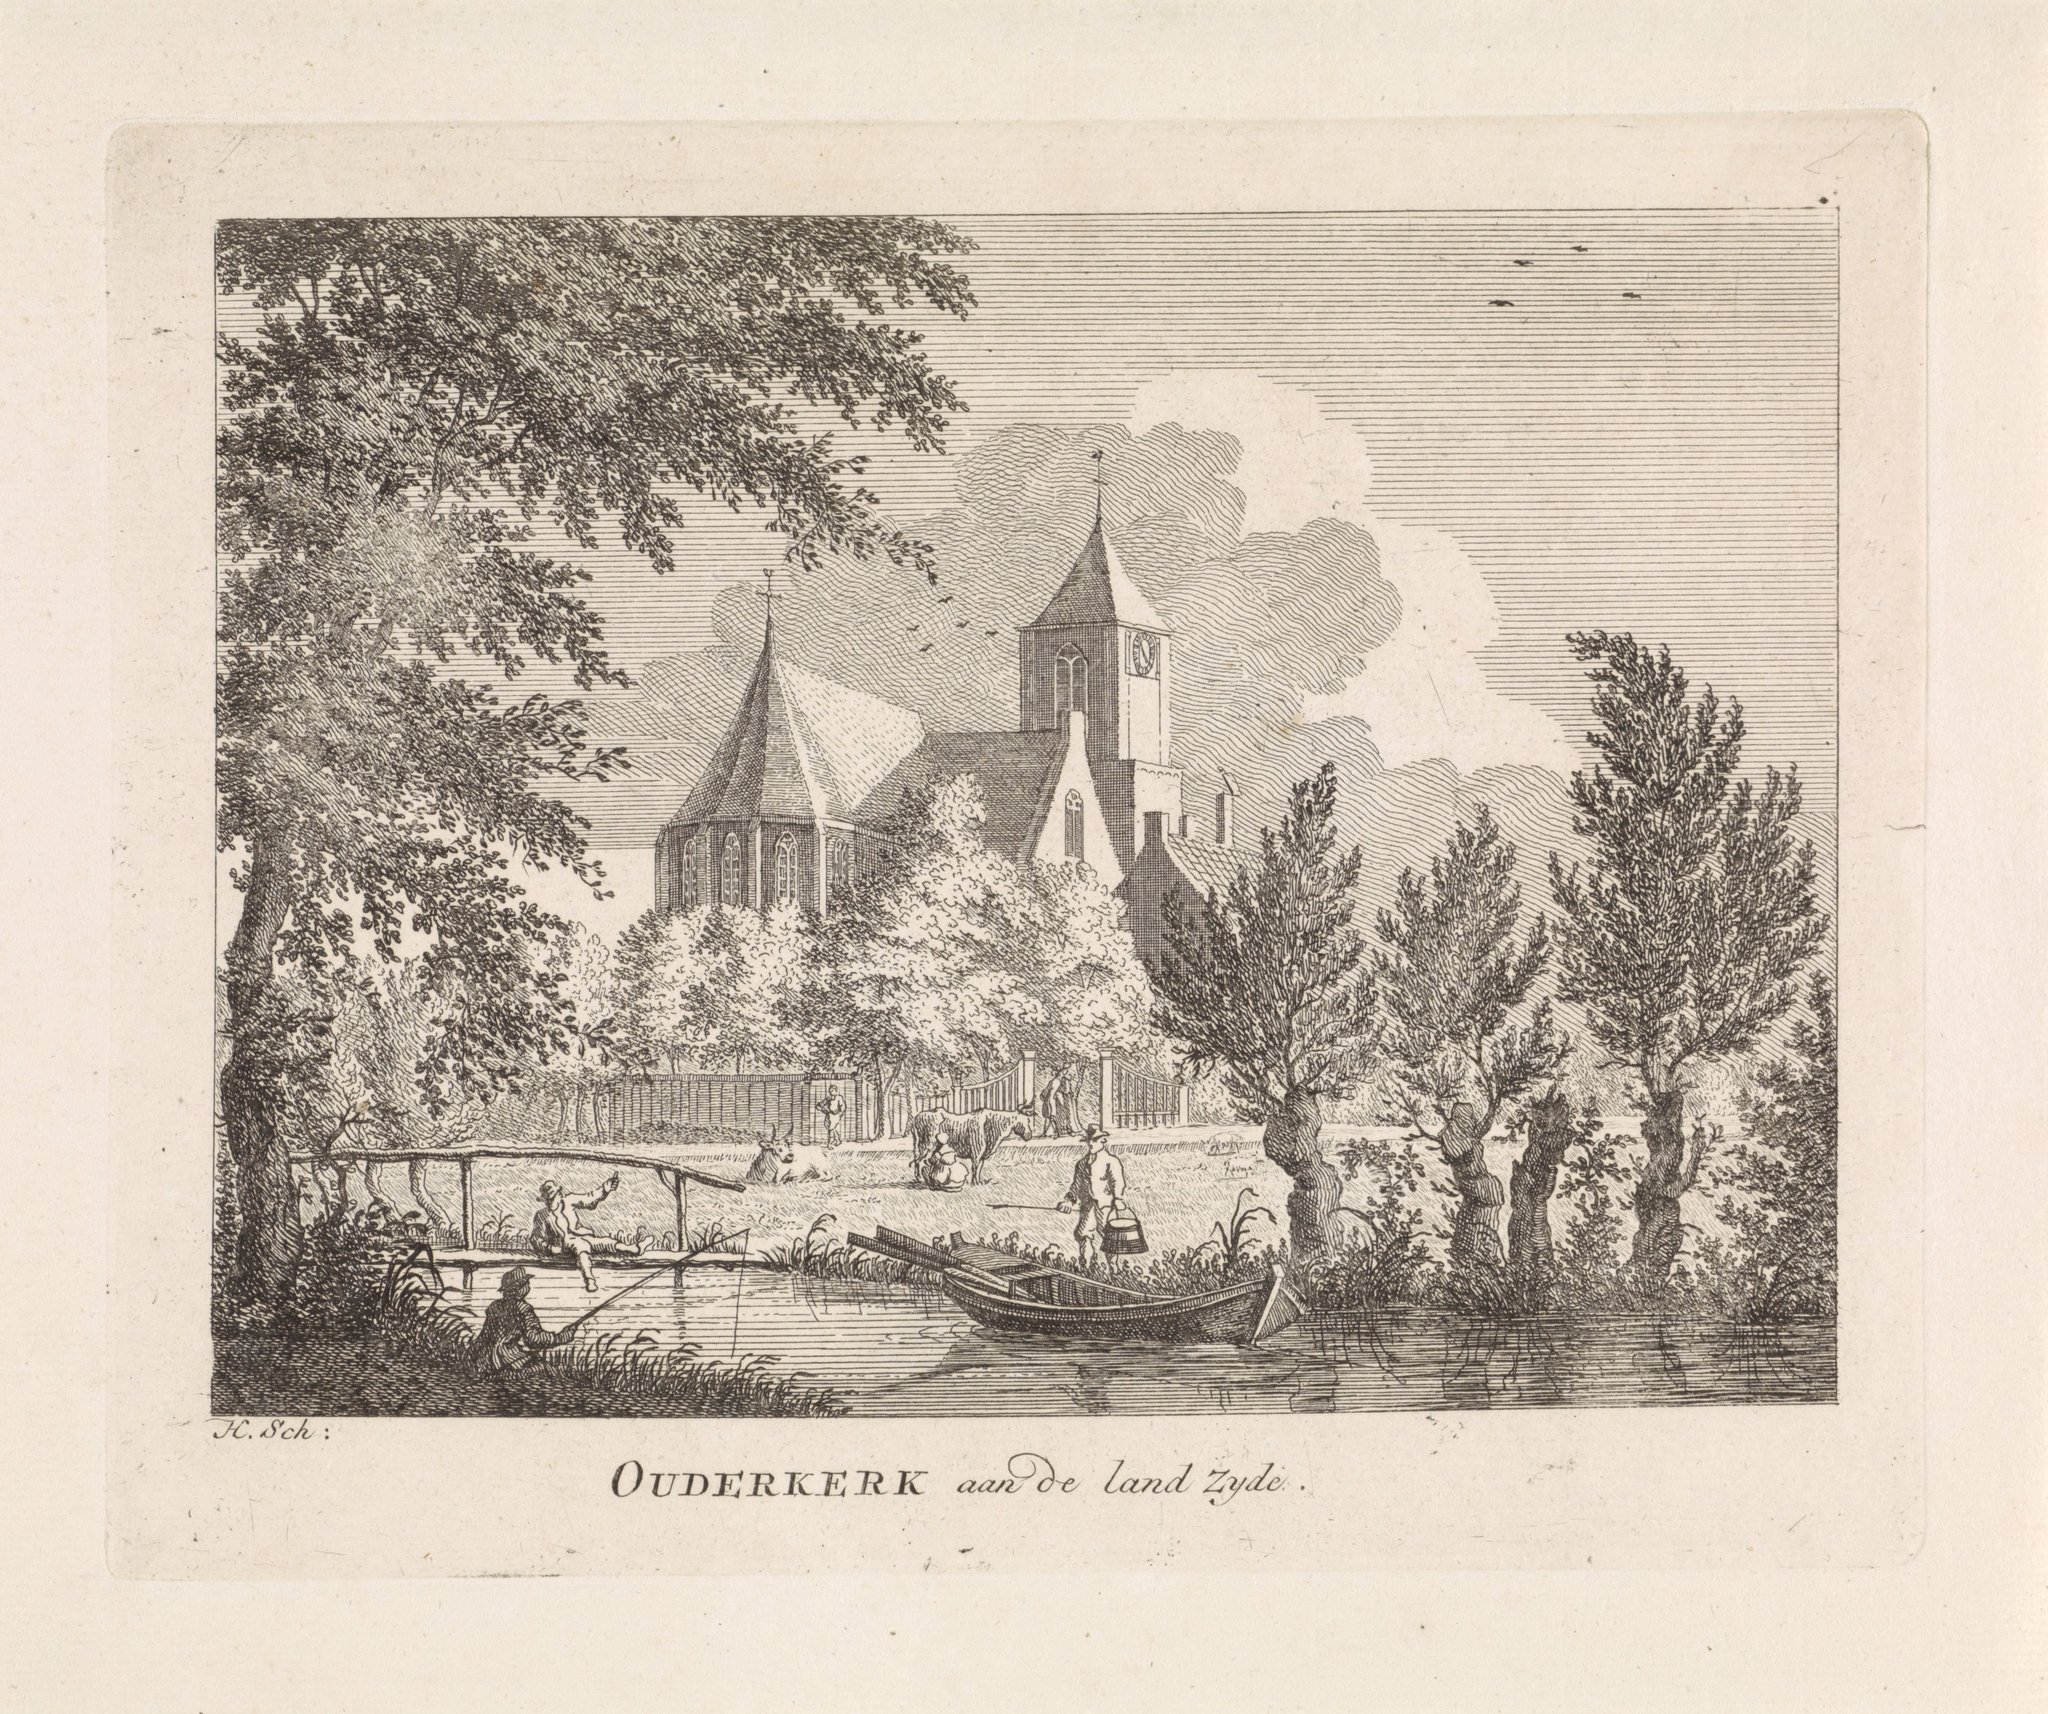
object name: print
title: Gezicht op Ouderkerk aan de Amstel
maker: hermanus petrus schouten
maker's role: draughtsman, painter, print maker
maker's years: 1747-1822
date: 1762-1822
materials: paper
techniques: etching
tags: village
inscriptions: collector's mark: Lugt 2228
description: Landelijk tafereel bij een sloot met knotwilgen met zicht op de kerk in Ouderkerk aan de Amstel.